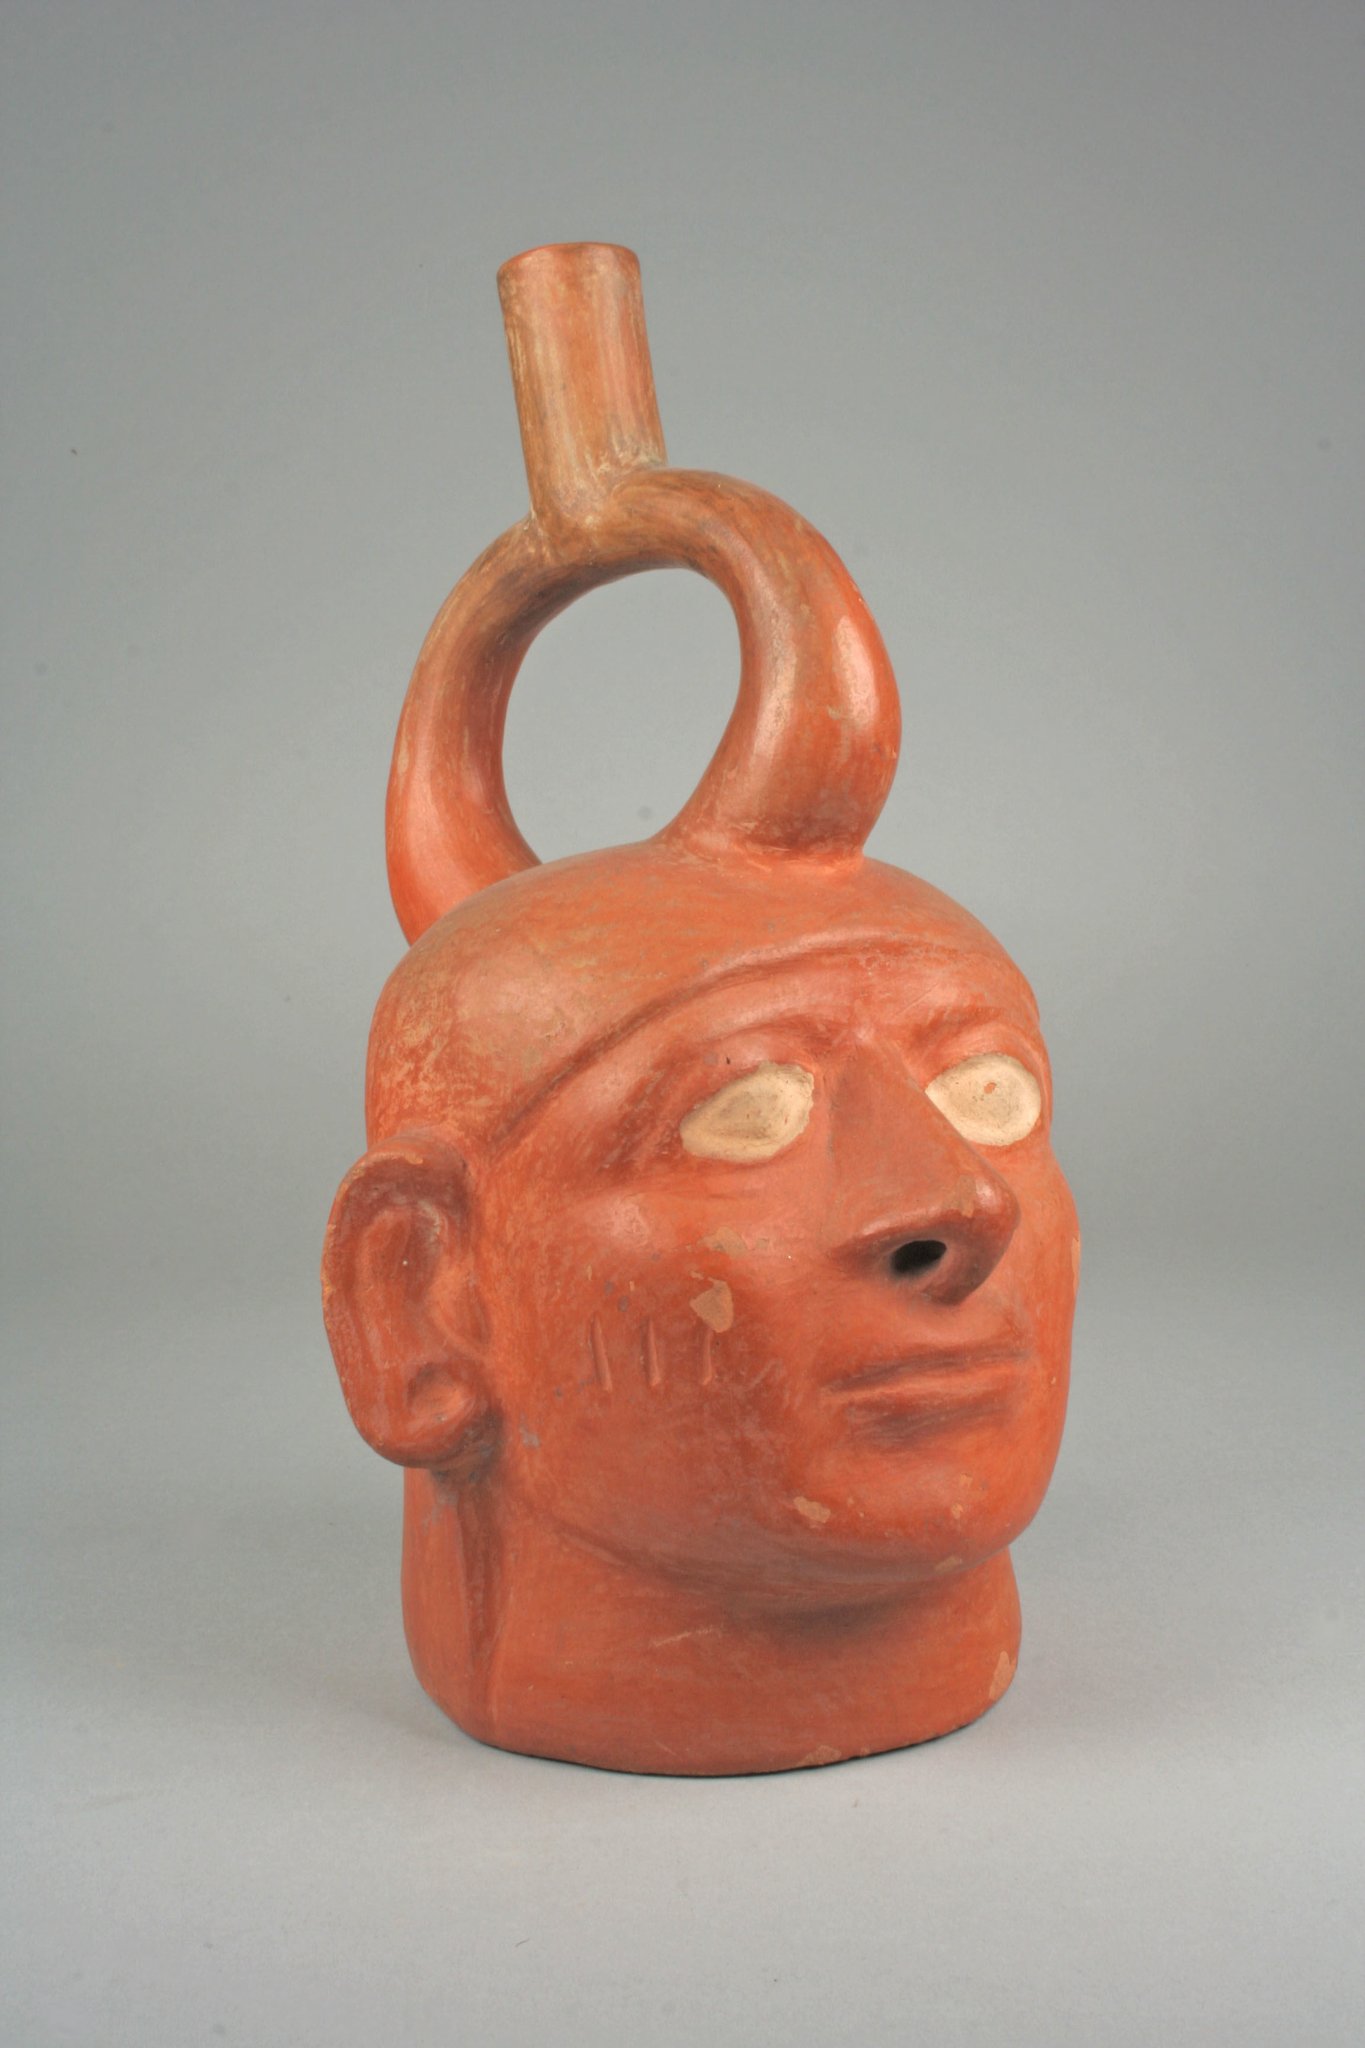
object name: bottle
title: Bottle, Head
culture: moche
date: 201-700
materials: ceramic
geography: peru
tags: heads